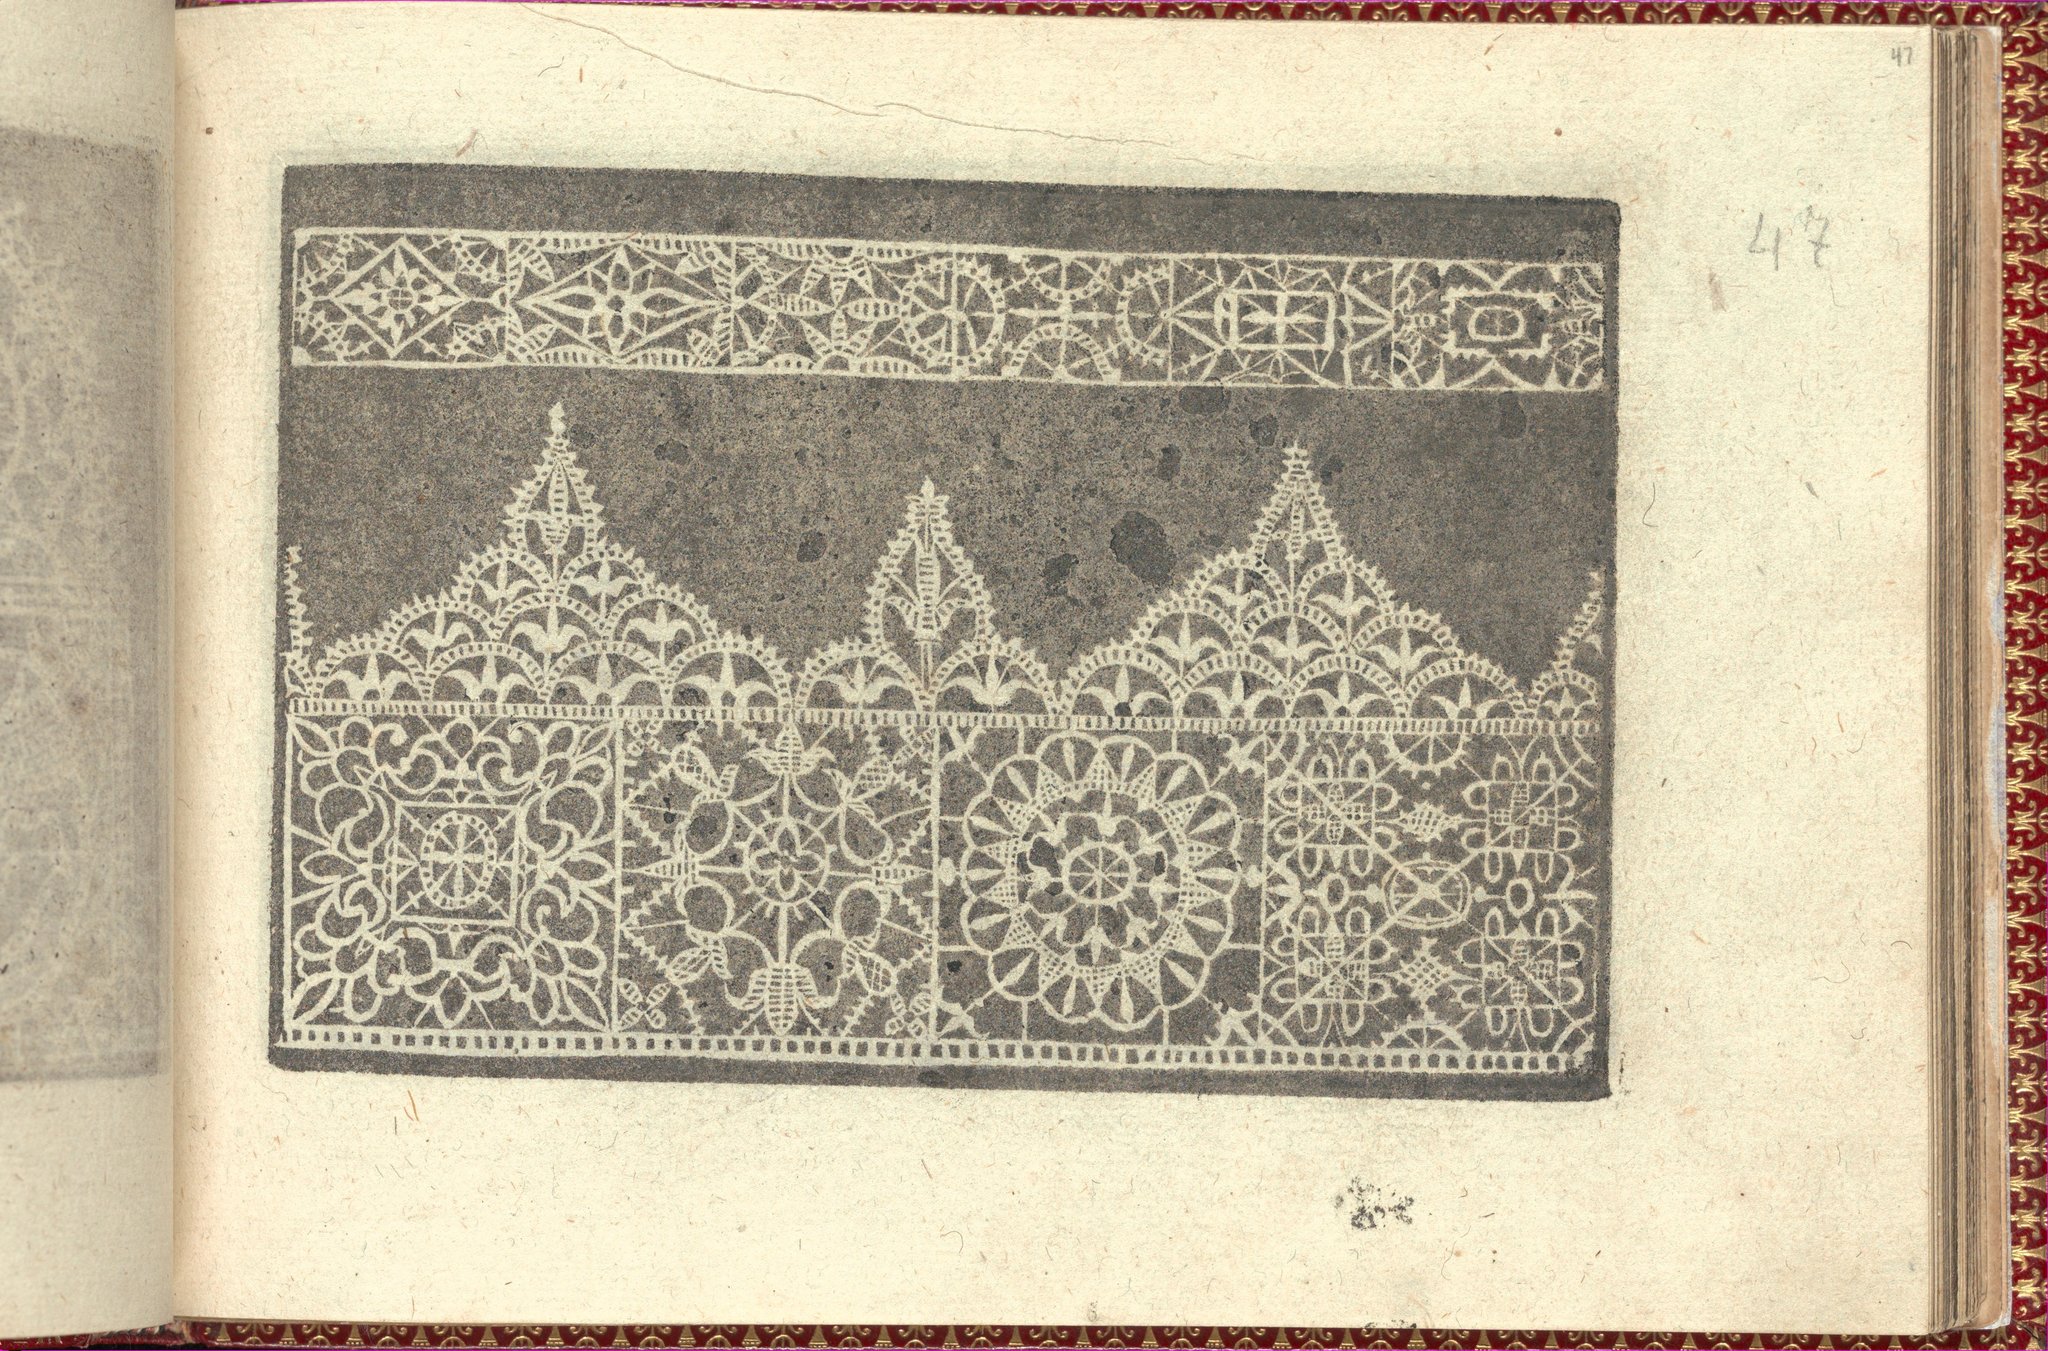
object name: book print ornament architecture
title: Corona delle Nobili et Virtuose Donne: Libro I-IV, page 47 (recto)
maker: cesare vecellio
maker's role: publisher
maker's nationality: italian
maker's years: 1521-1601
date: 1601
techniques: woodcut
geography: italy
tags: ornament